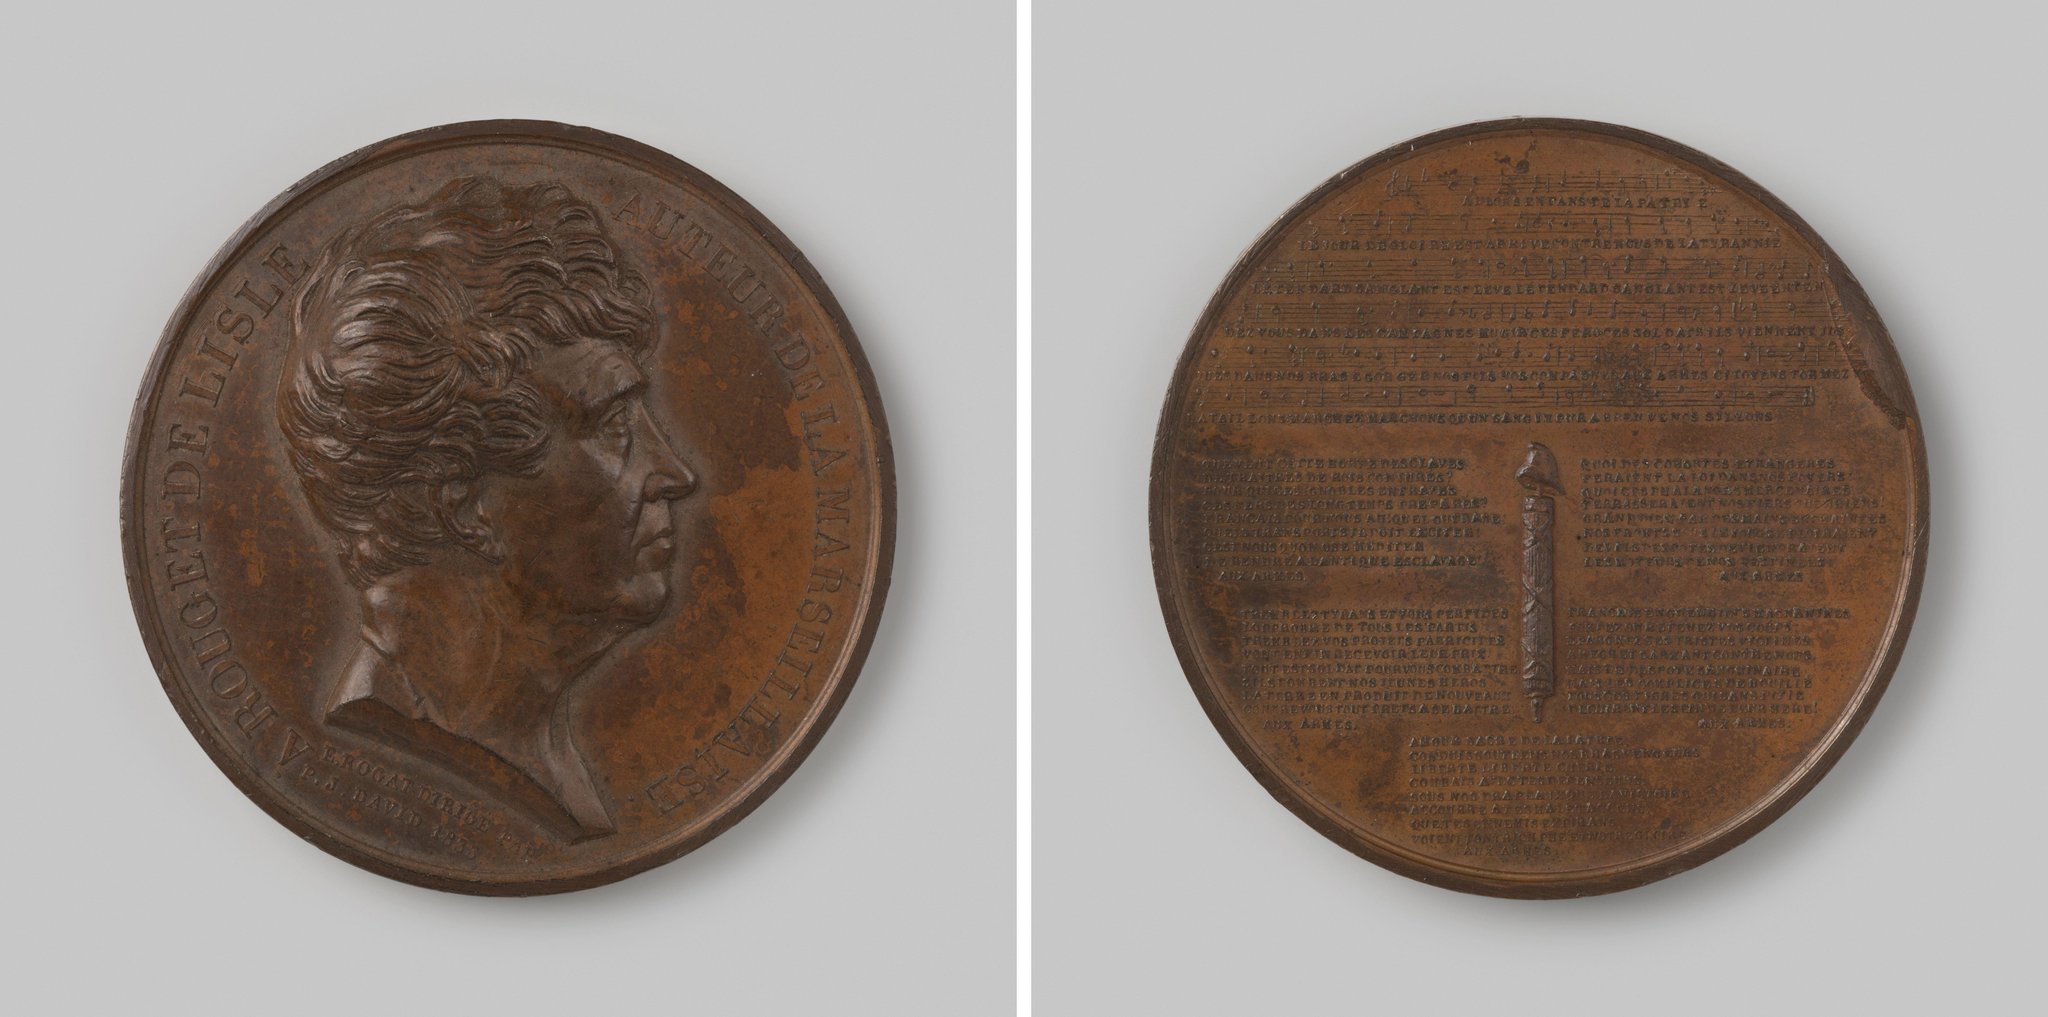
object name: history medal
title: Overlijden van C.J. Rouget de Lisle, schrijver van de Marseillaise, 1836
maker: emile rogat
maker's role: medailleur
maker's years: 1799-1852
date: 1843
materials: bronze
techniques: striking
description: Bronzen penning, op de voorzijde het portret van Rouget de Lisle naar rechts met omschrift, op de keerzijde rond een fasces met phrygische muts in kleine letters de tekst van de zes coupletten van de Marseillaise, waarvan de bovenste met muziek.